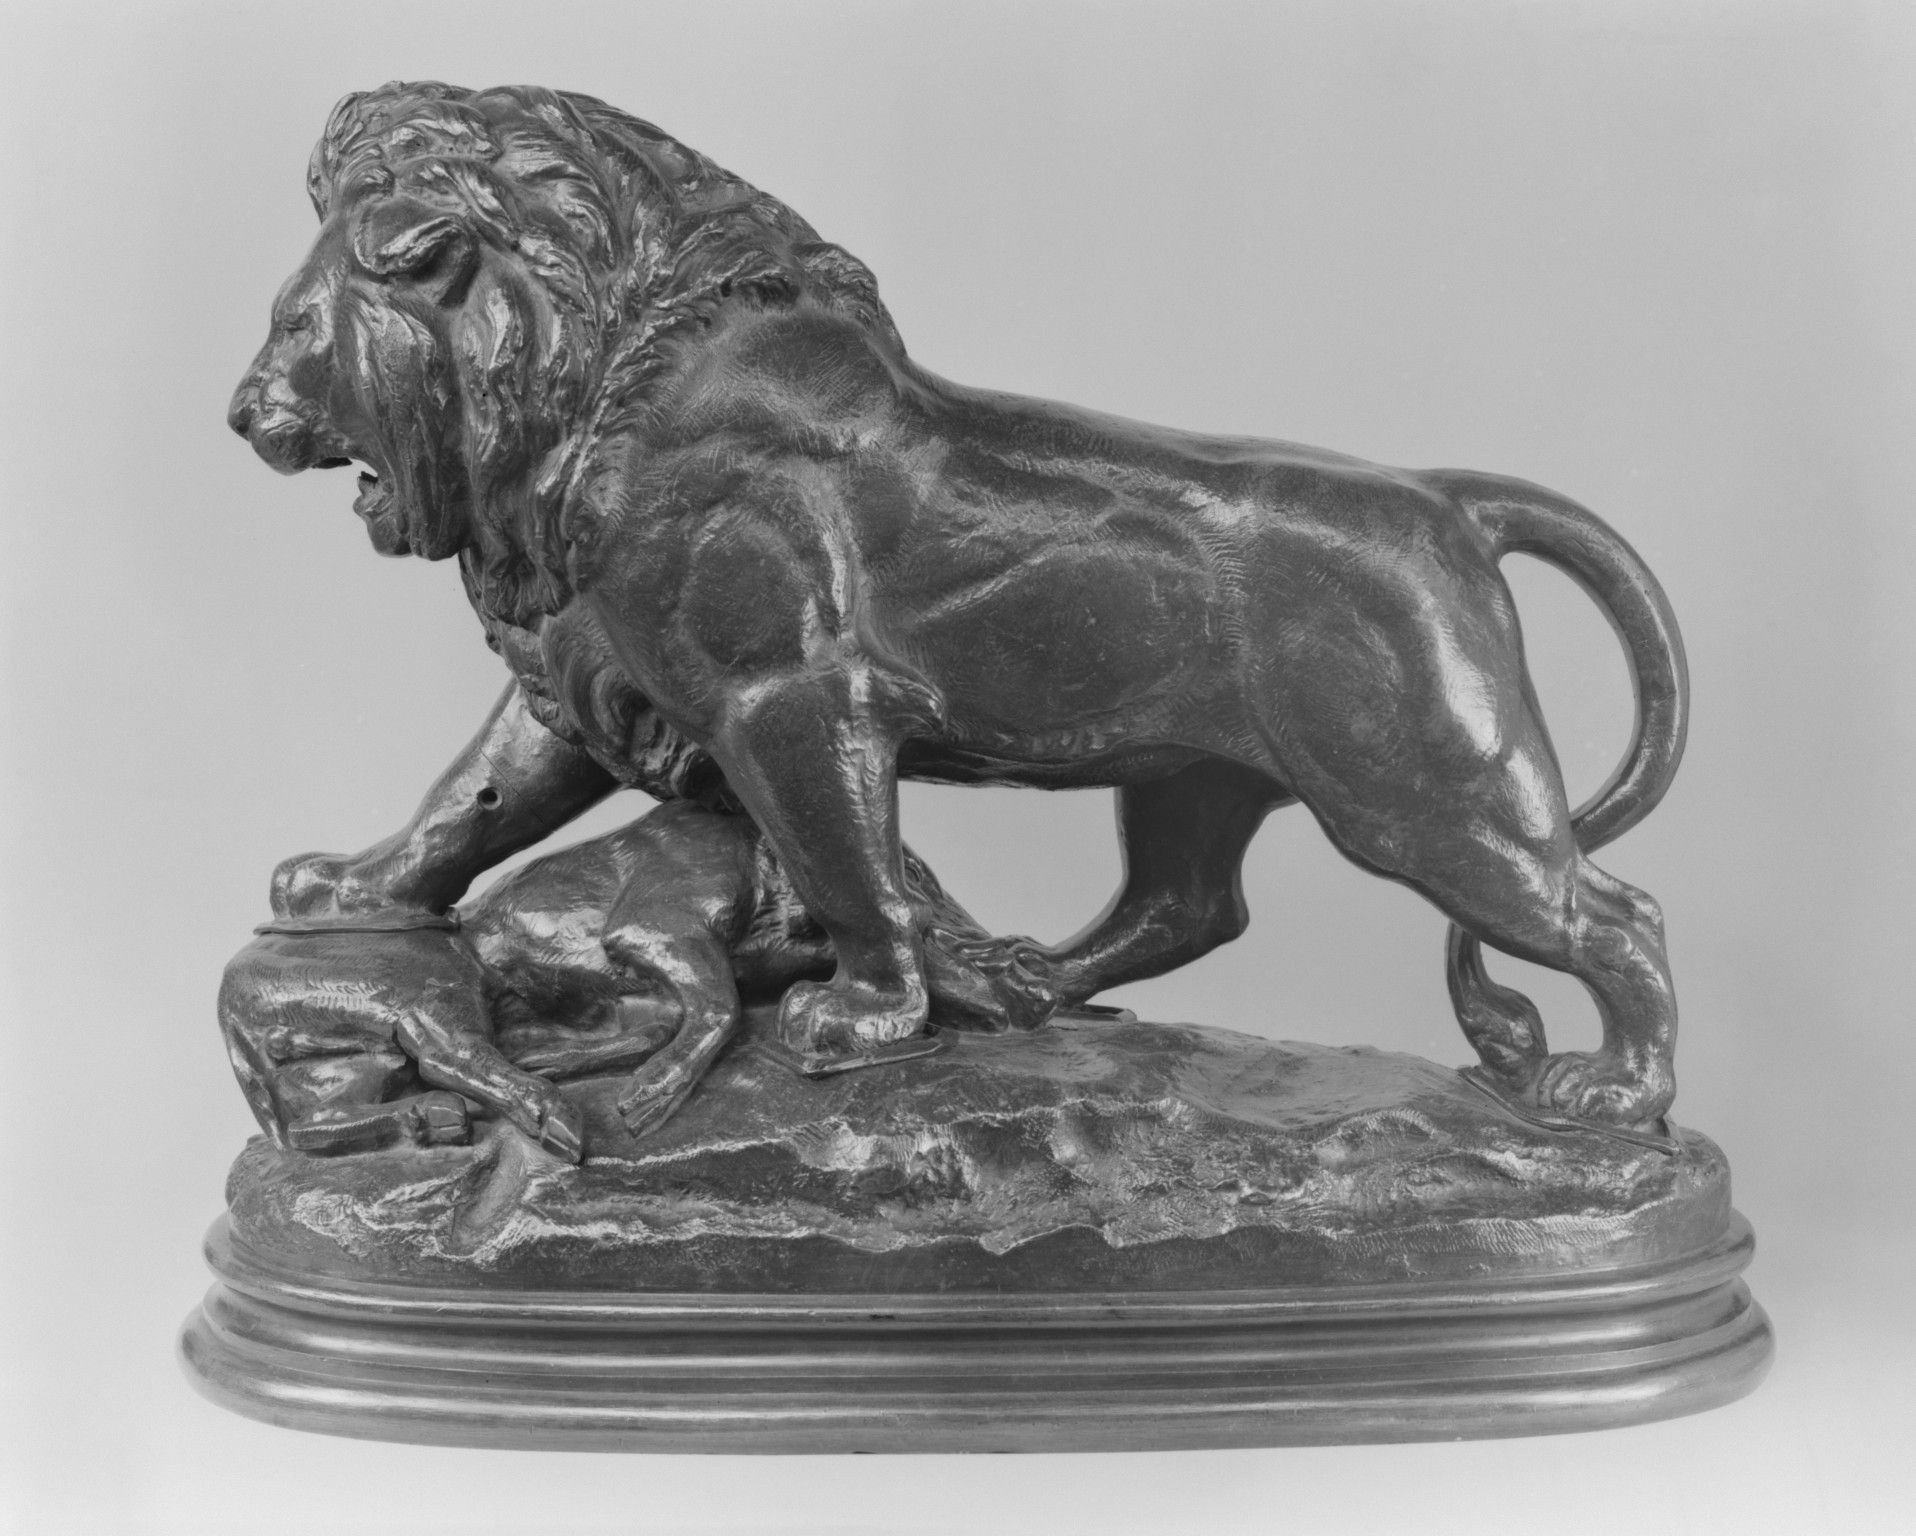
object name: statuette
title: Lion with Boar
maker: antoine-louis barye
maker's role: artist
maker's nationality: french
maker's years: 1795-1875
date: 1801-1900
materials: bronze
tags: boars,lions